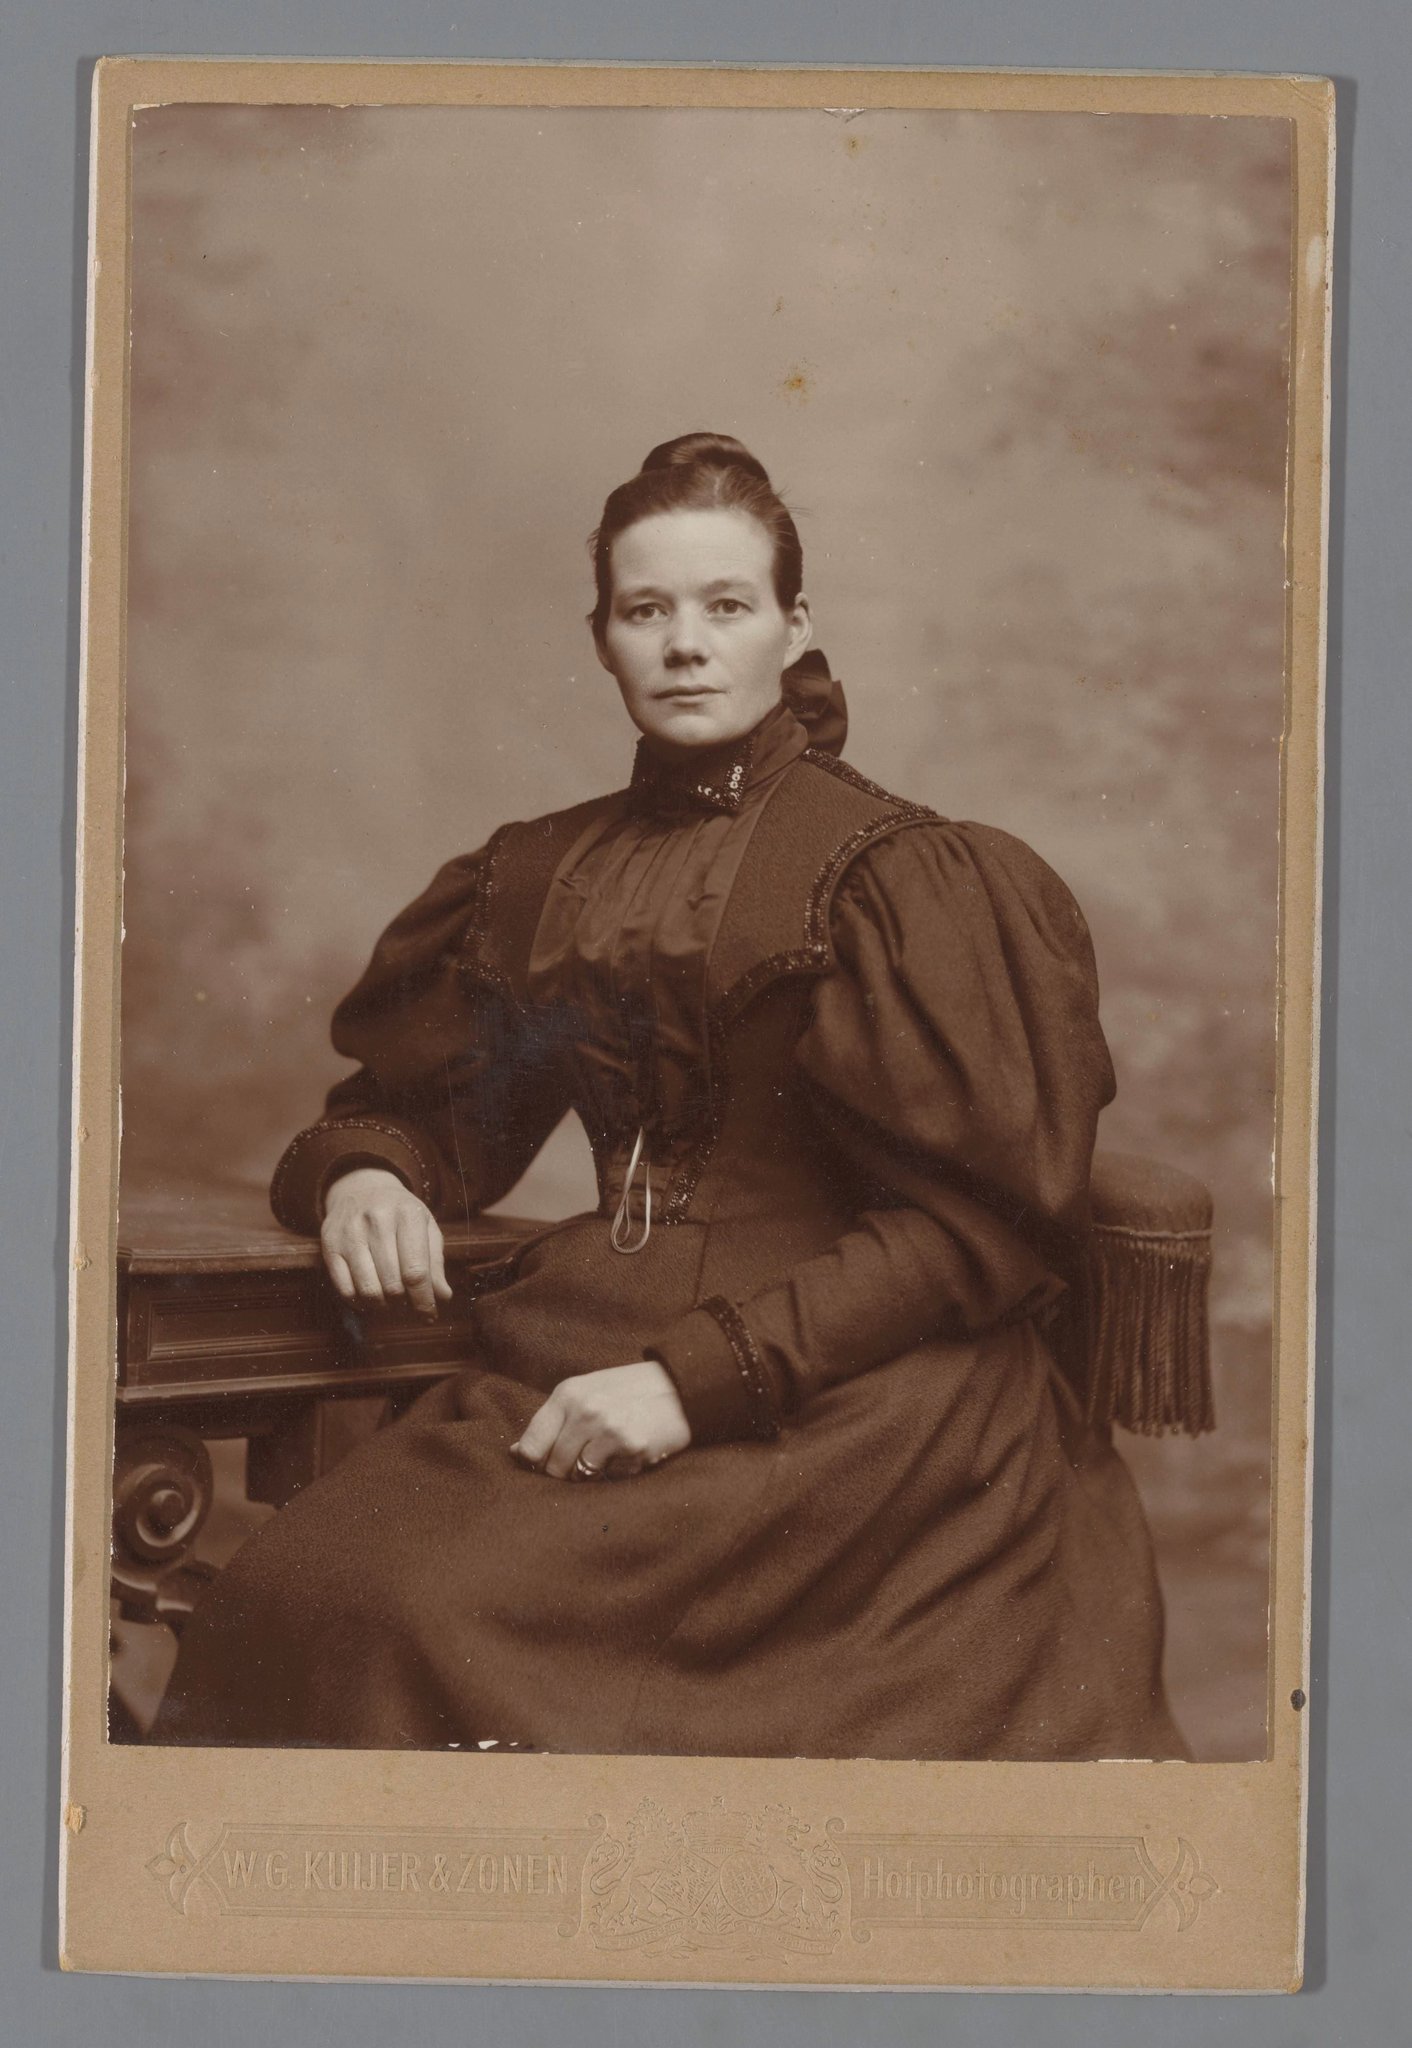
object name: cabinet photograph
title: Portret van een onbekende vrouw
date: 1885-1906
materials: cardboard, photographic support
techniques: gelatin silver print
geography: amsterdam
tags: adult woman, studio requisites ~ photographer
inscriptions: name: ‘W.G. Kuijer & Zonen Hofphotographen Westermarkt 19, Amsterdam.’